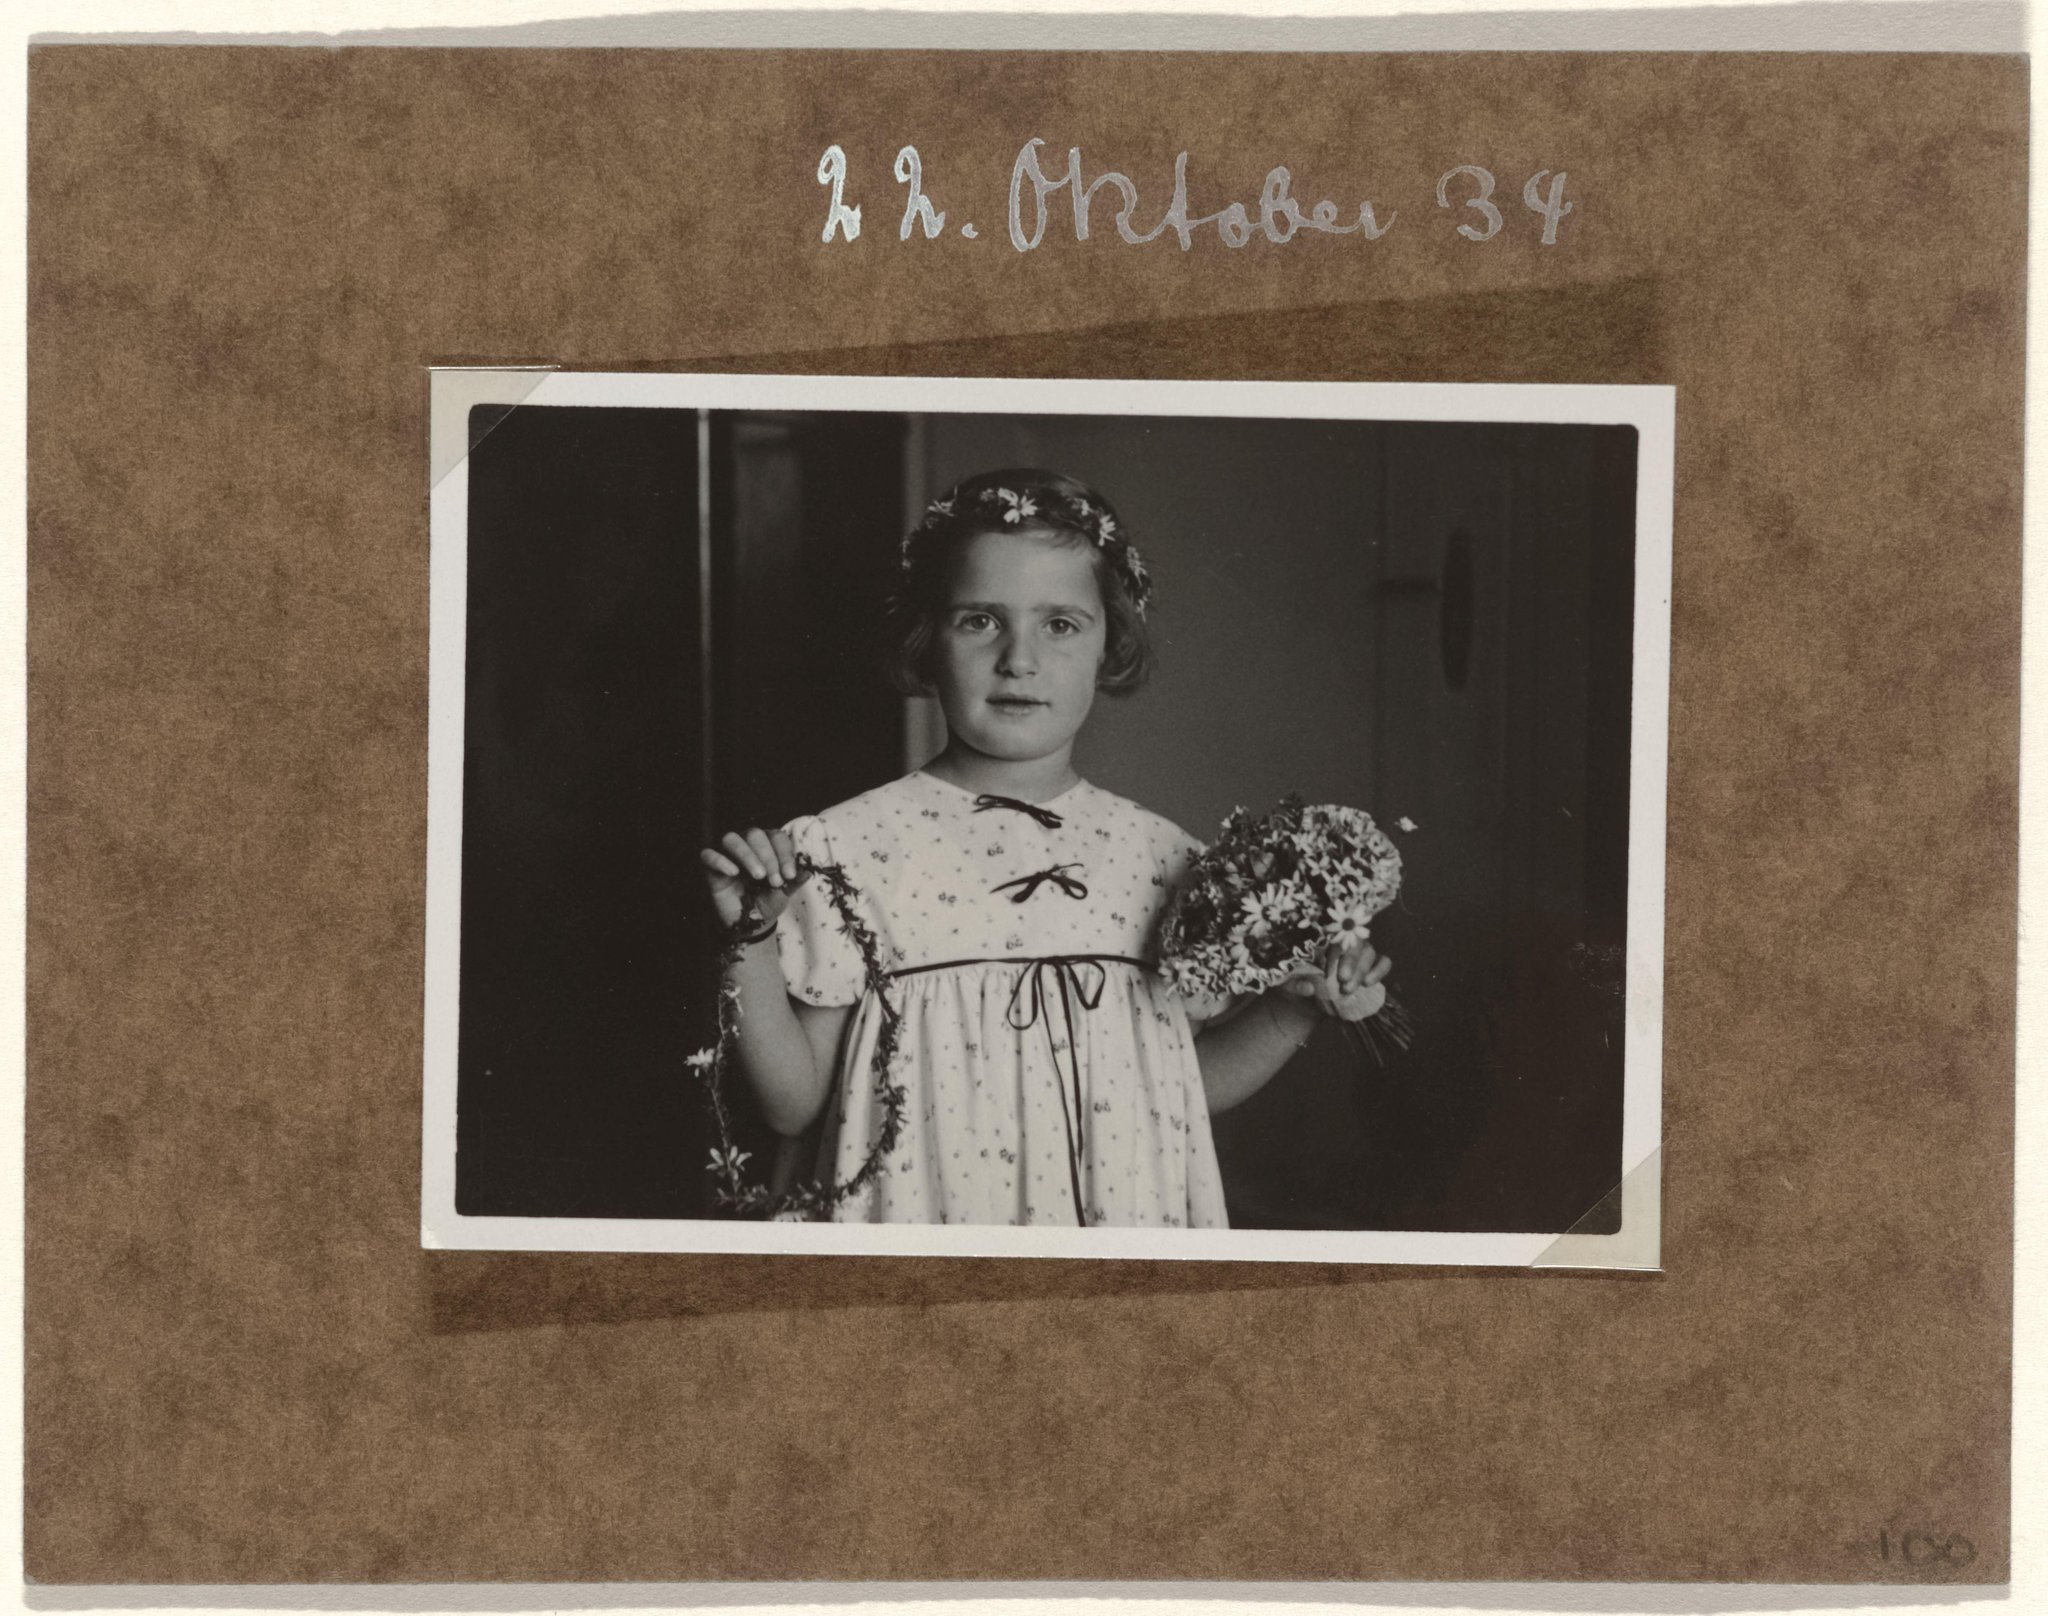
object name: photograph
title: Isabel Wachenheimer met bloemen in haar hand en in het haar tijdens het gouden huwelijksjubileum van Mathilde Wachenheimer-Wertheimer en Meir Wachenheimer, op 22 oktober 1934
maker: Anonymous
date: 1934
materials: photographic support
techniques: gelatin silver print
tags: isabel wachenheimer-elon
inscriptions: date: ‘22. Oktober 34’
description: Isabel Wachenheimer met bloemen in haar hand en in het haar. De foto is genomen tijdens het gouden huwelijksjubileum van Isabel's grootouders Mathilde Wachenheimer-Wertheimer en Meir Wachenheimer, op 22 oktober 1934.